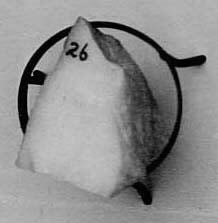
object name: fragment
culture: burmese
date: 1902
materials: jade